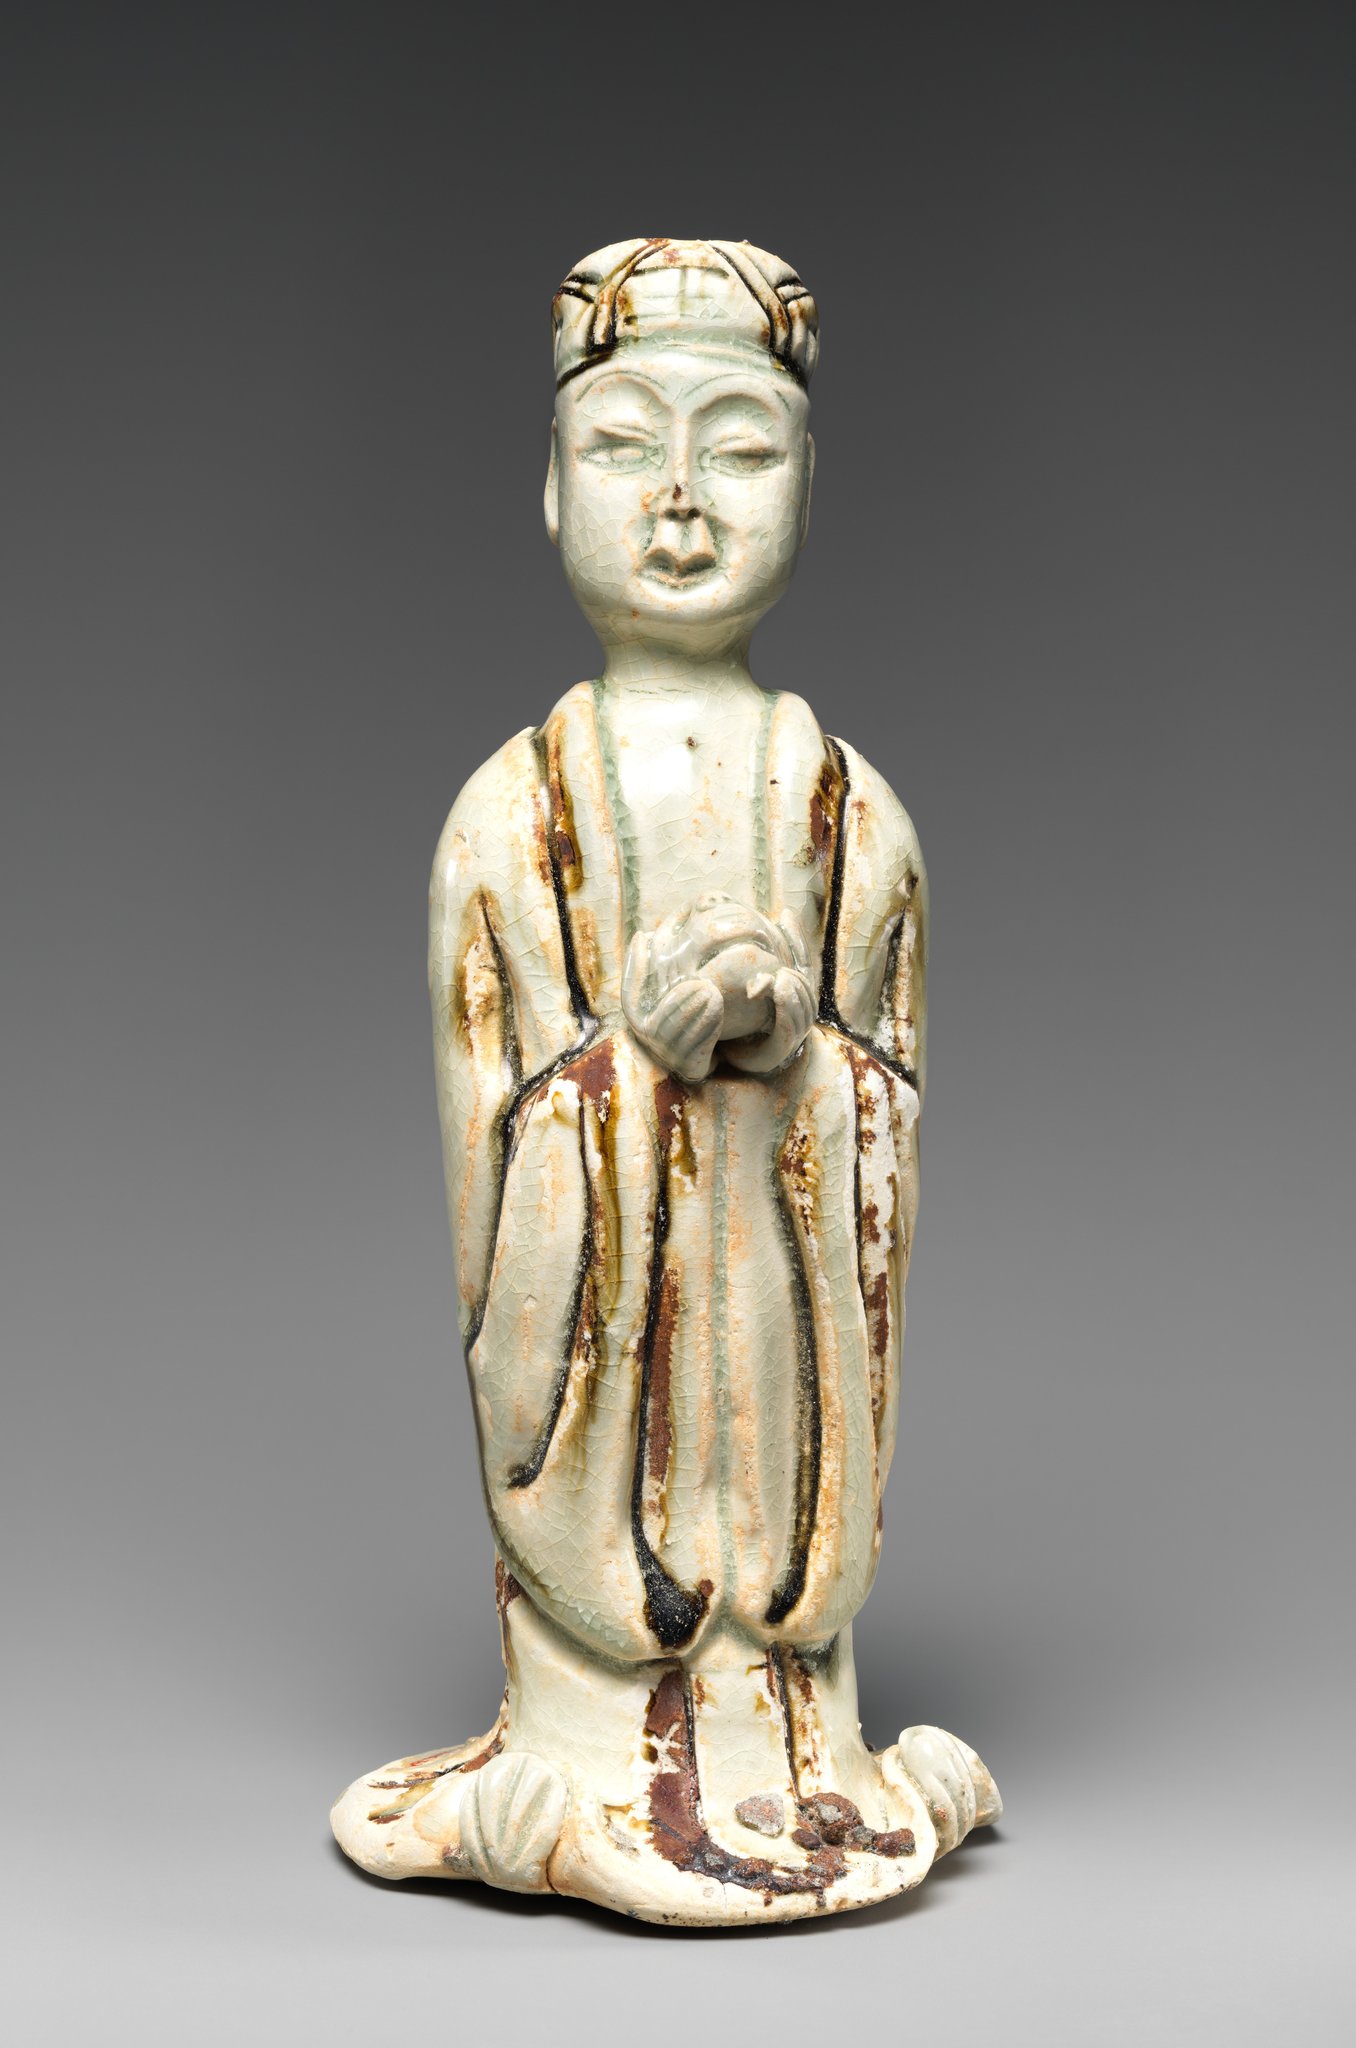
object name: figure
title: Daoist Priest with Zodiac Animal, Monkey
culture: chinese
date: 960-1279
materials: stoneware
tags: animals,men